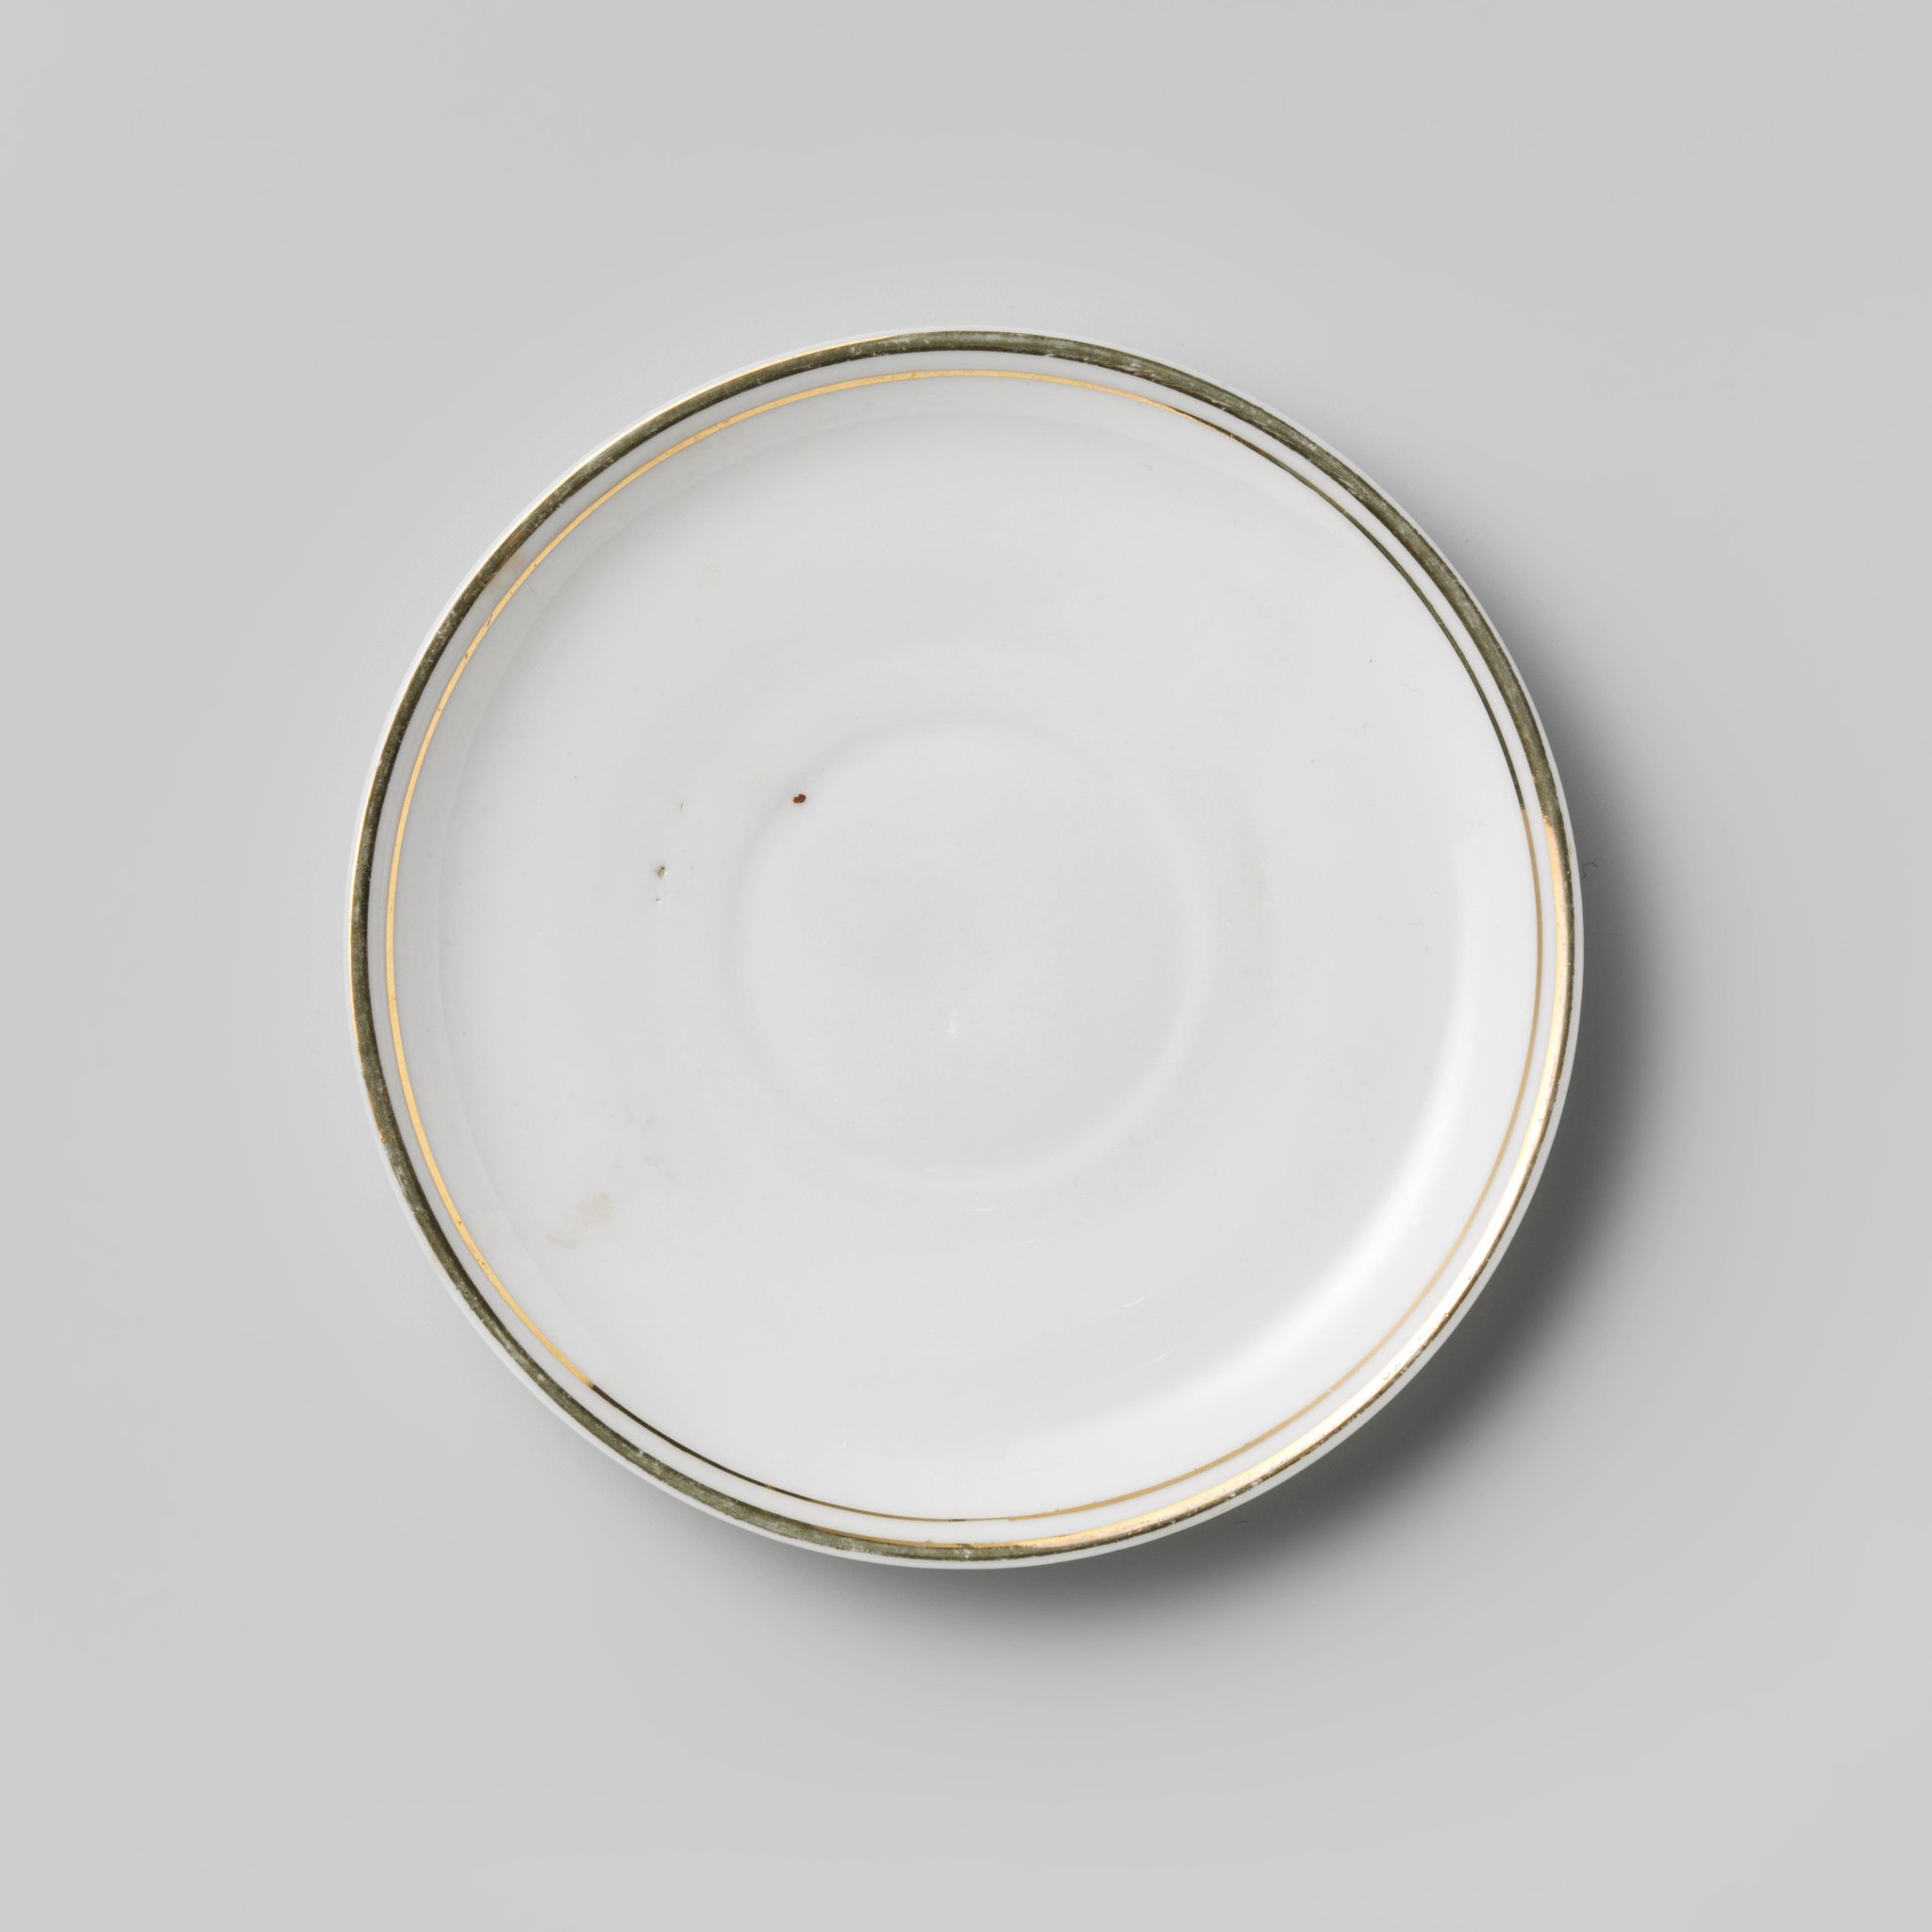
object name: object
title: Schotel (zonder afbeelding)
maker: Anonymous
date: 1850-1949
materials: ceramic